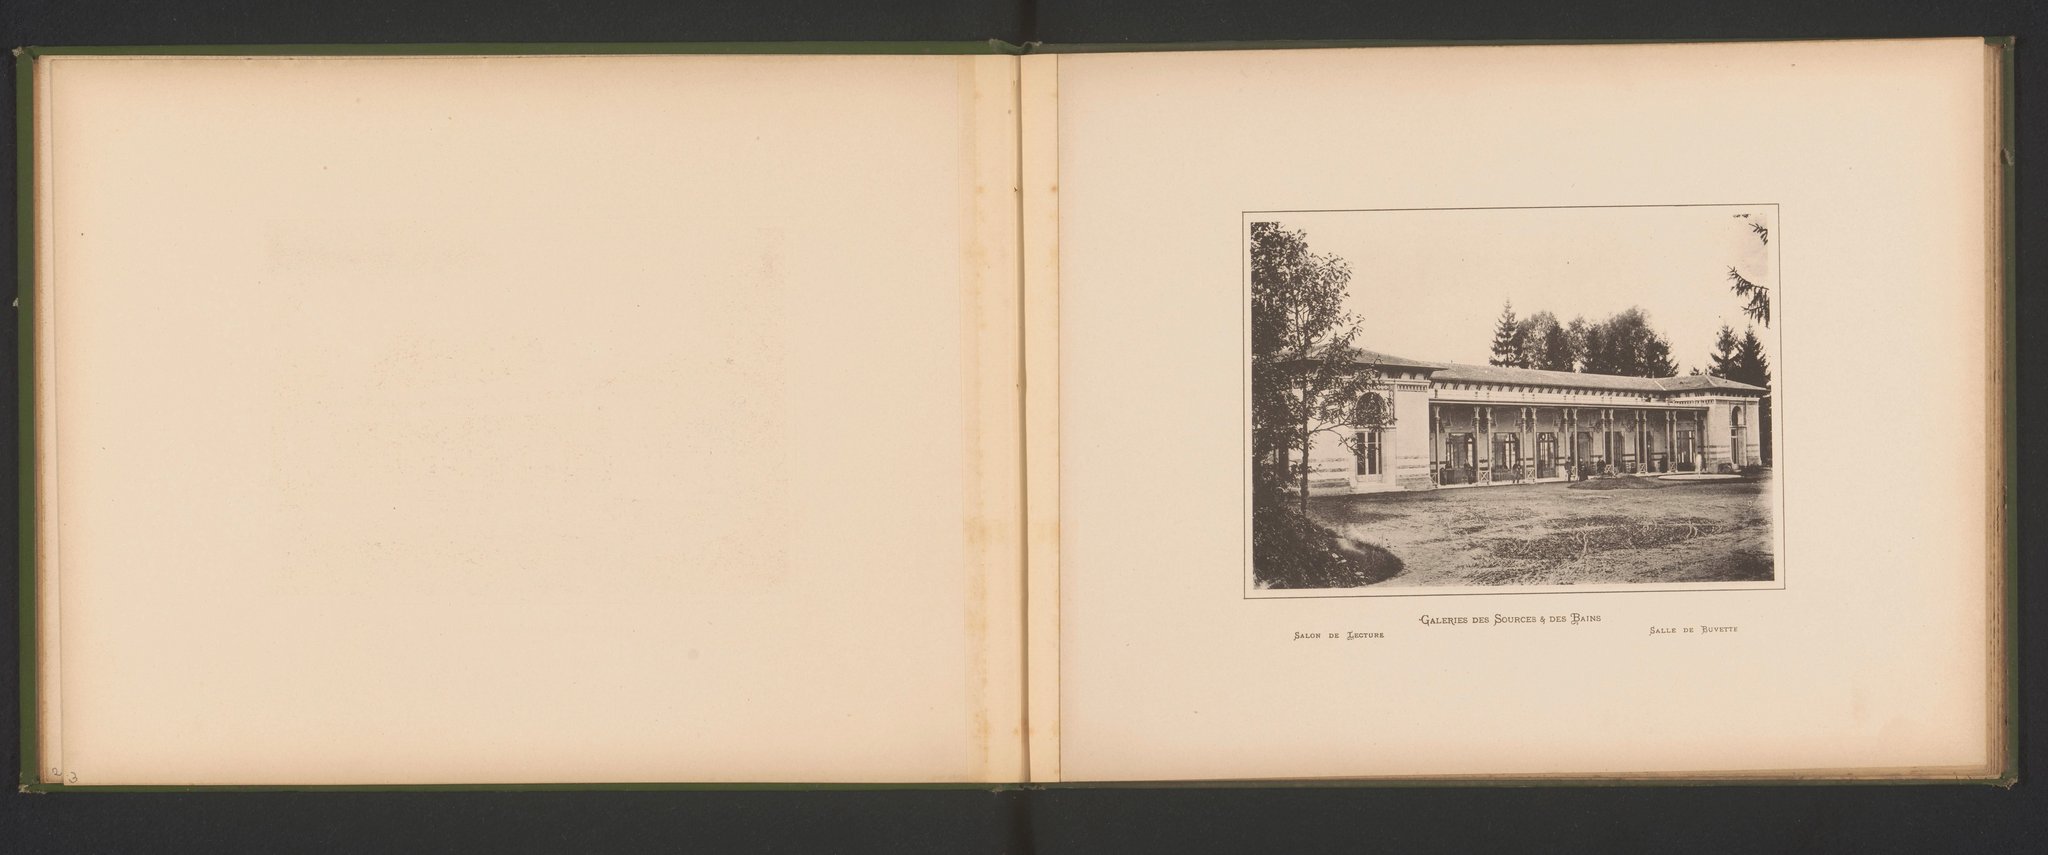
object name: page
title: Gezicht op het badhuis in Vittel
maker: Anonymous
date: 1885-1890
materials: paper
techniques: photograph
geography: vittel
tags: public baths, spring (fluids extracted from the earth)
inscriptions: inscription: ‘Salon de Lecture Salle de Buvette’